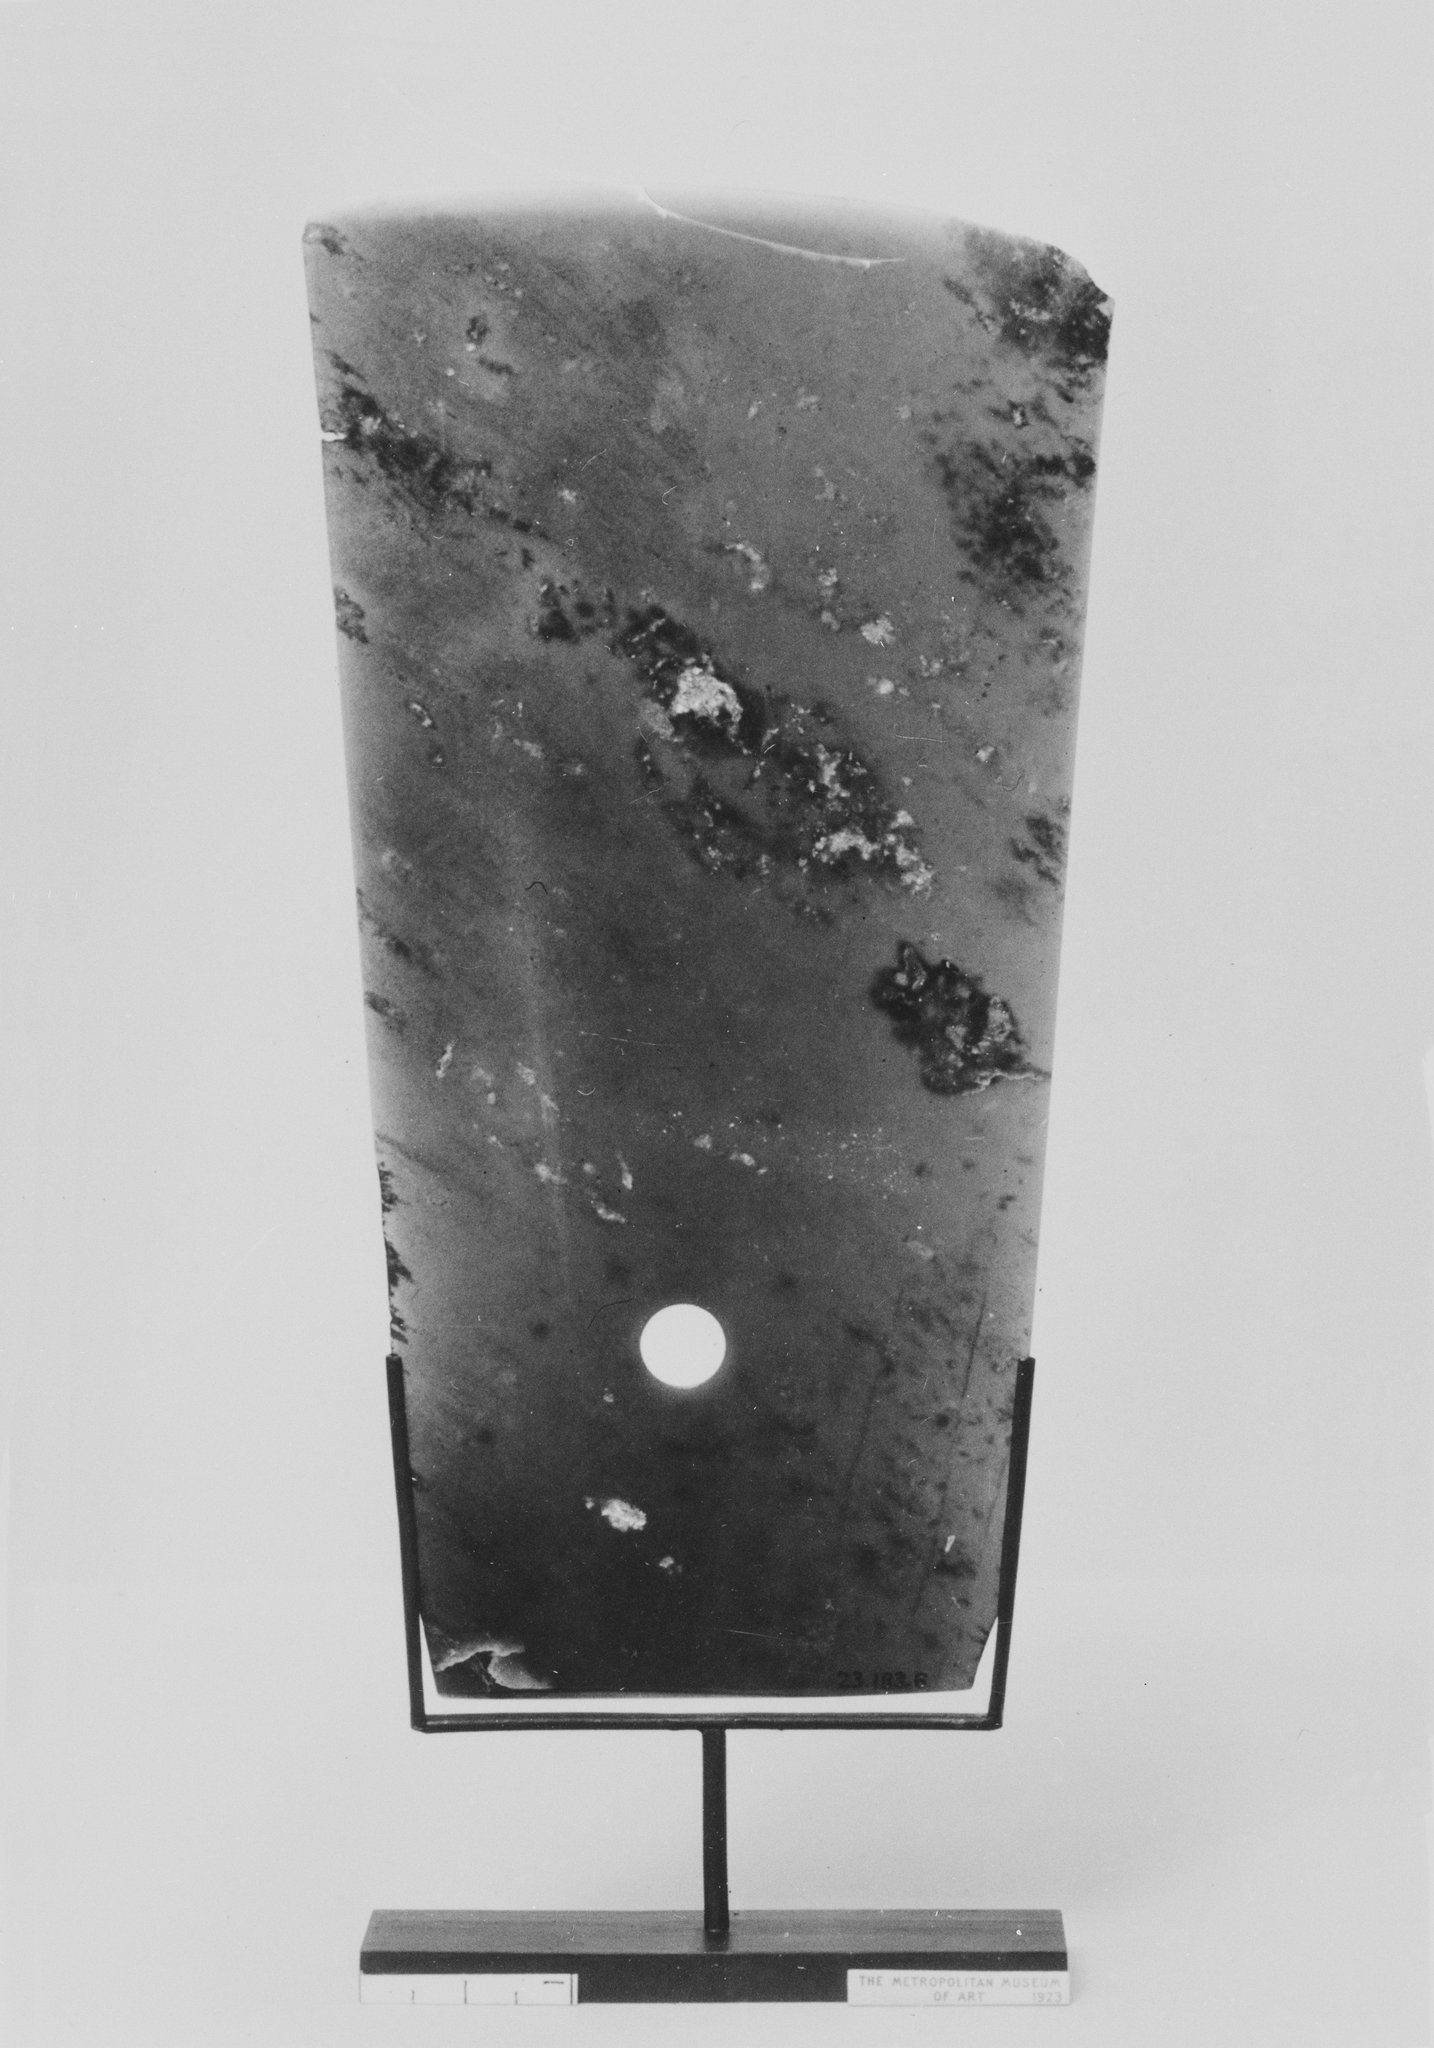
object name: ceremonial blade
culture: chinese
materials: jade